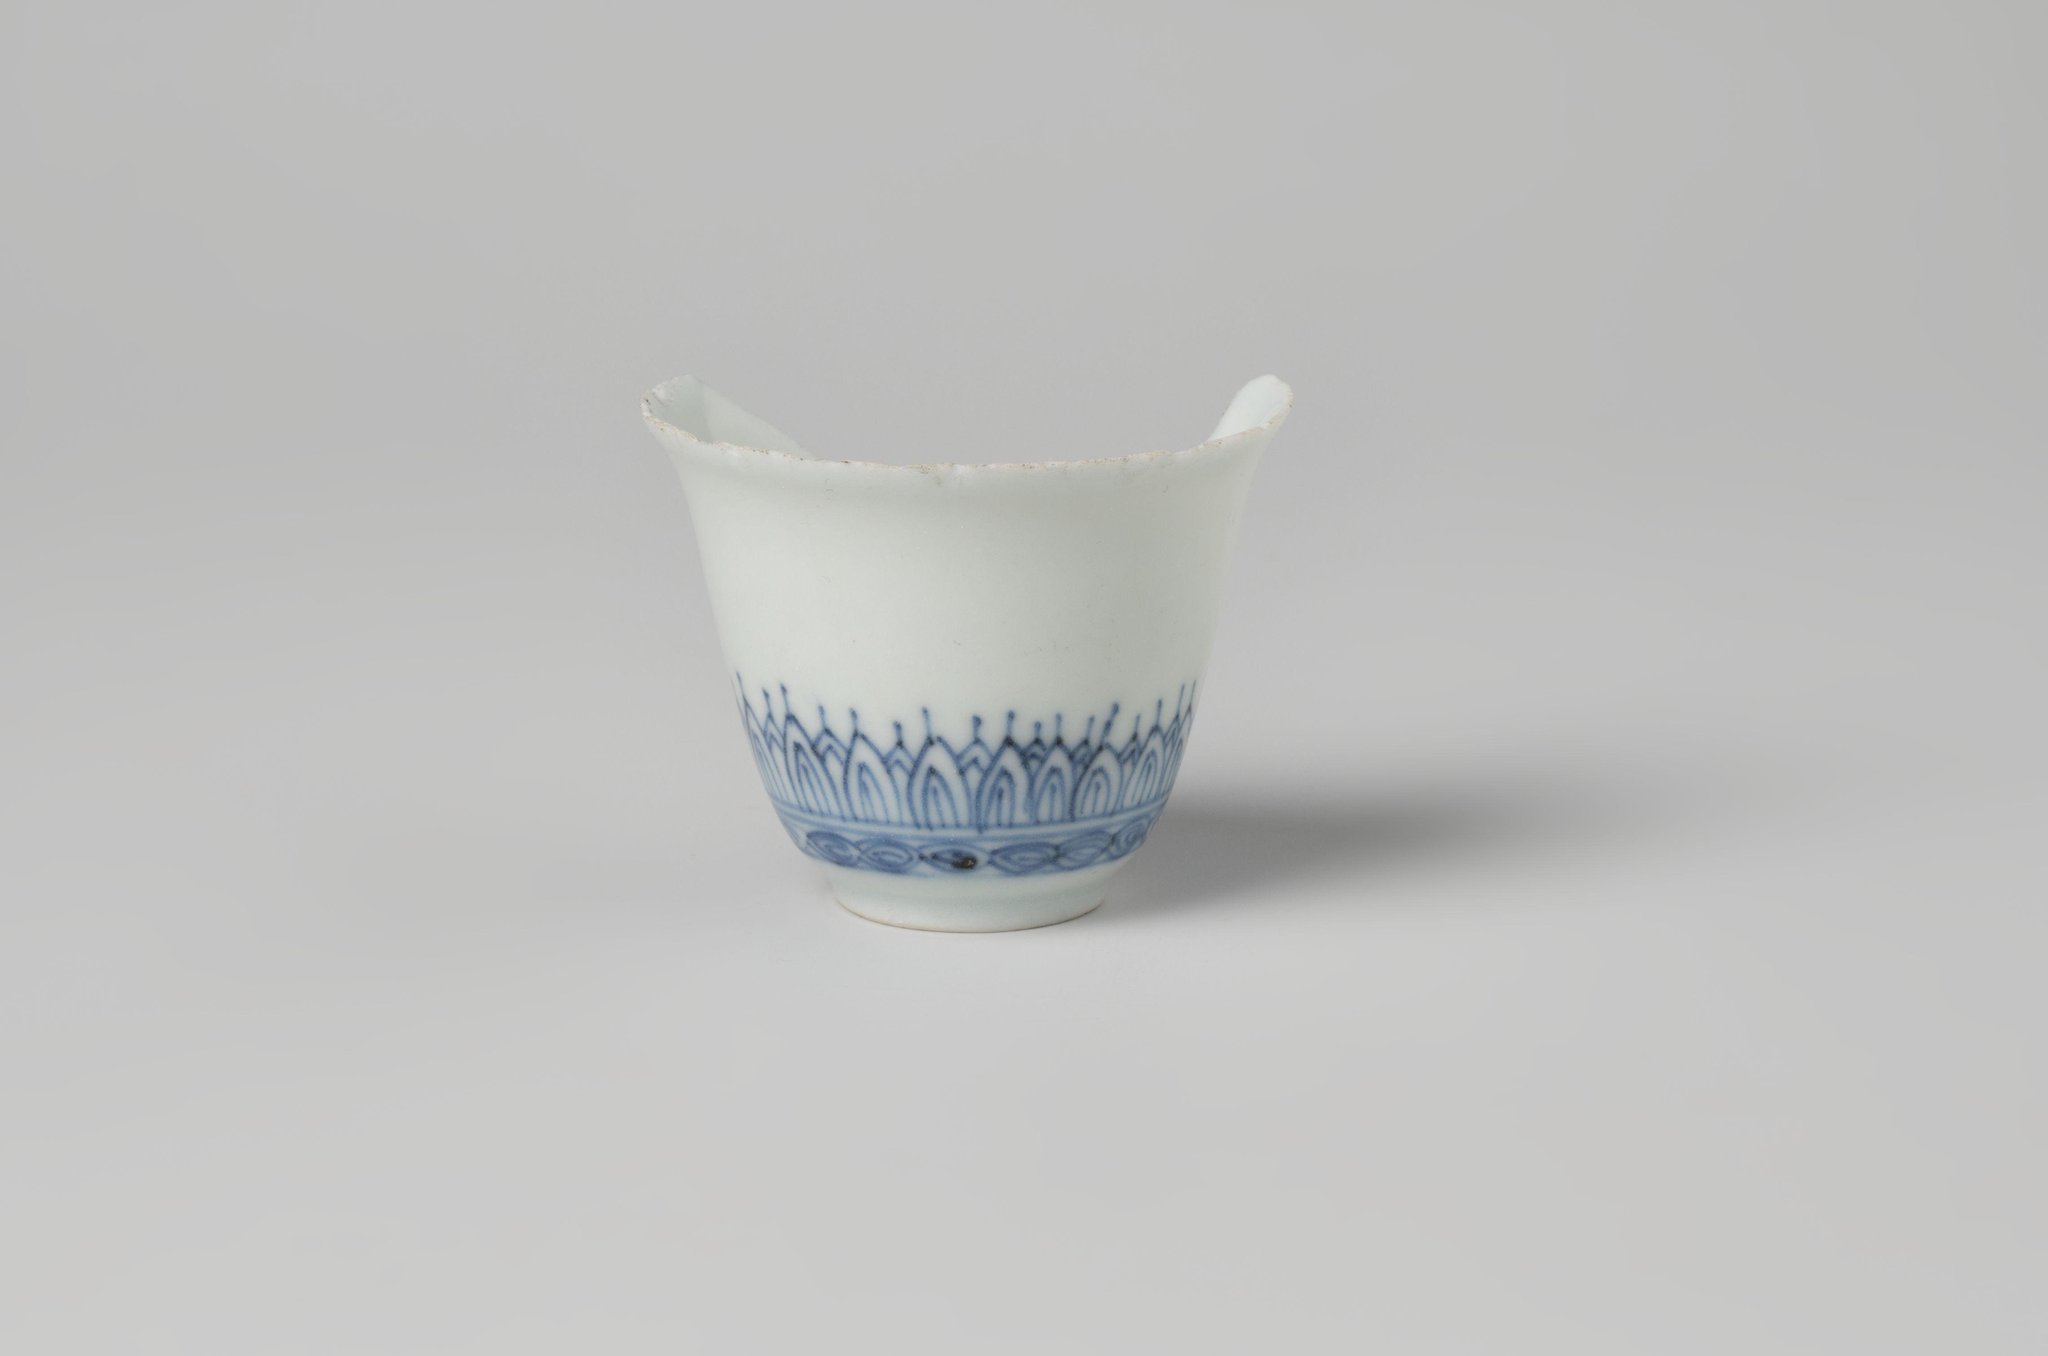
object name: wine cup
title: Fragment of a winecup of Chinese porcelain from the wreck of the Dutch East Indiaman Witte Leeuw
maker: Anonymous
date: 1613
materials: bone china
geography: jingdezhen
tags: verenigde oostindische compagnie, sint-helena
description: Very fine porcelein. Fine winecup with a delicately painted frieze of flames under which a band with scroll design.